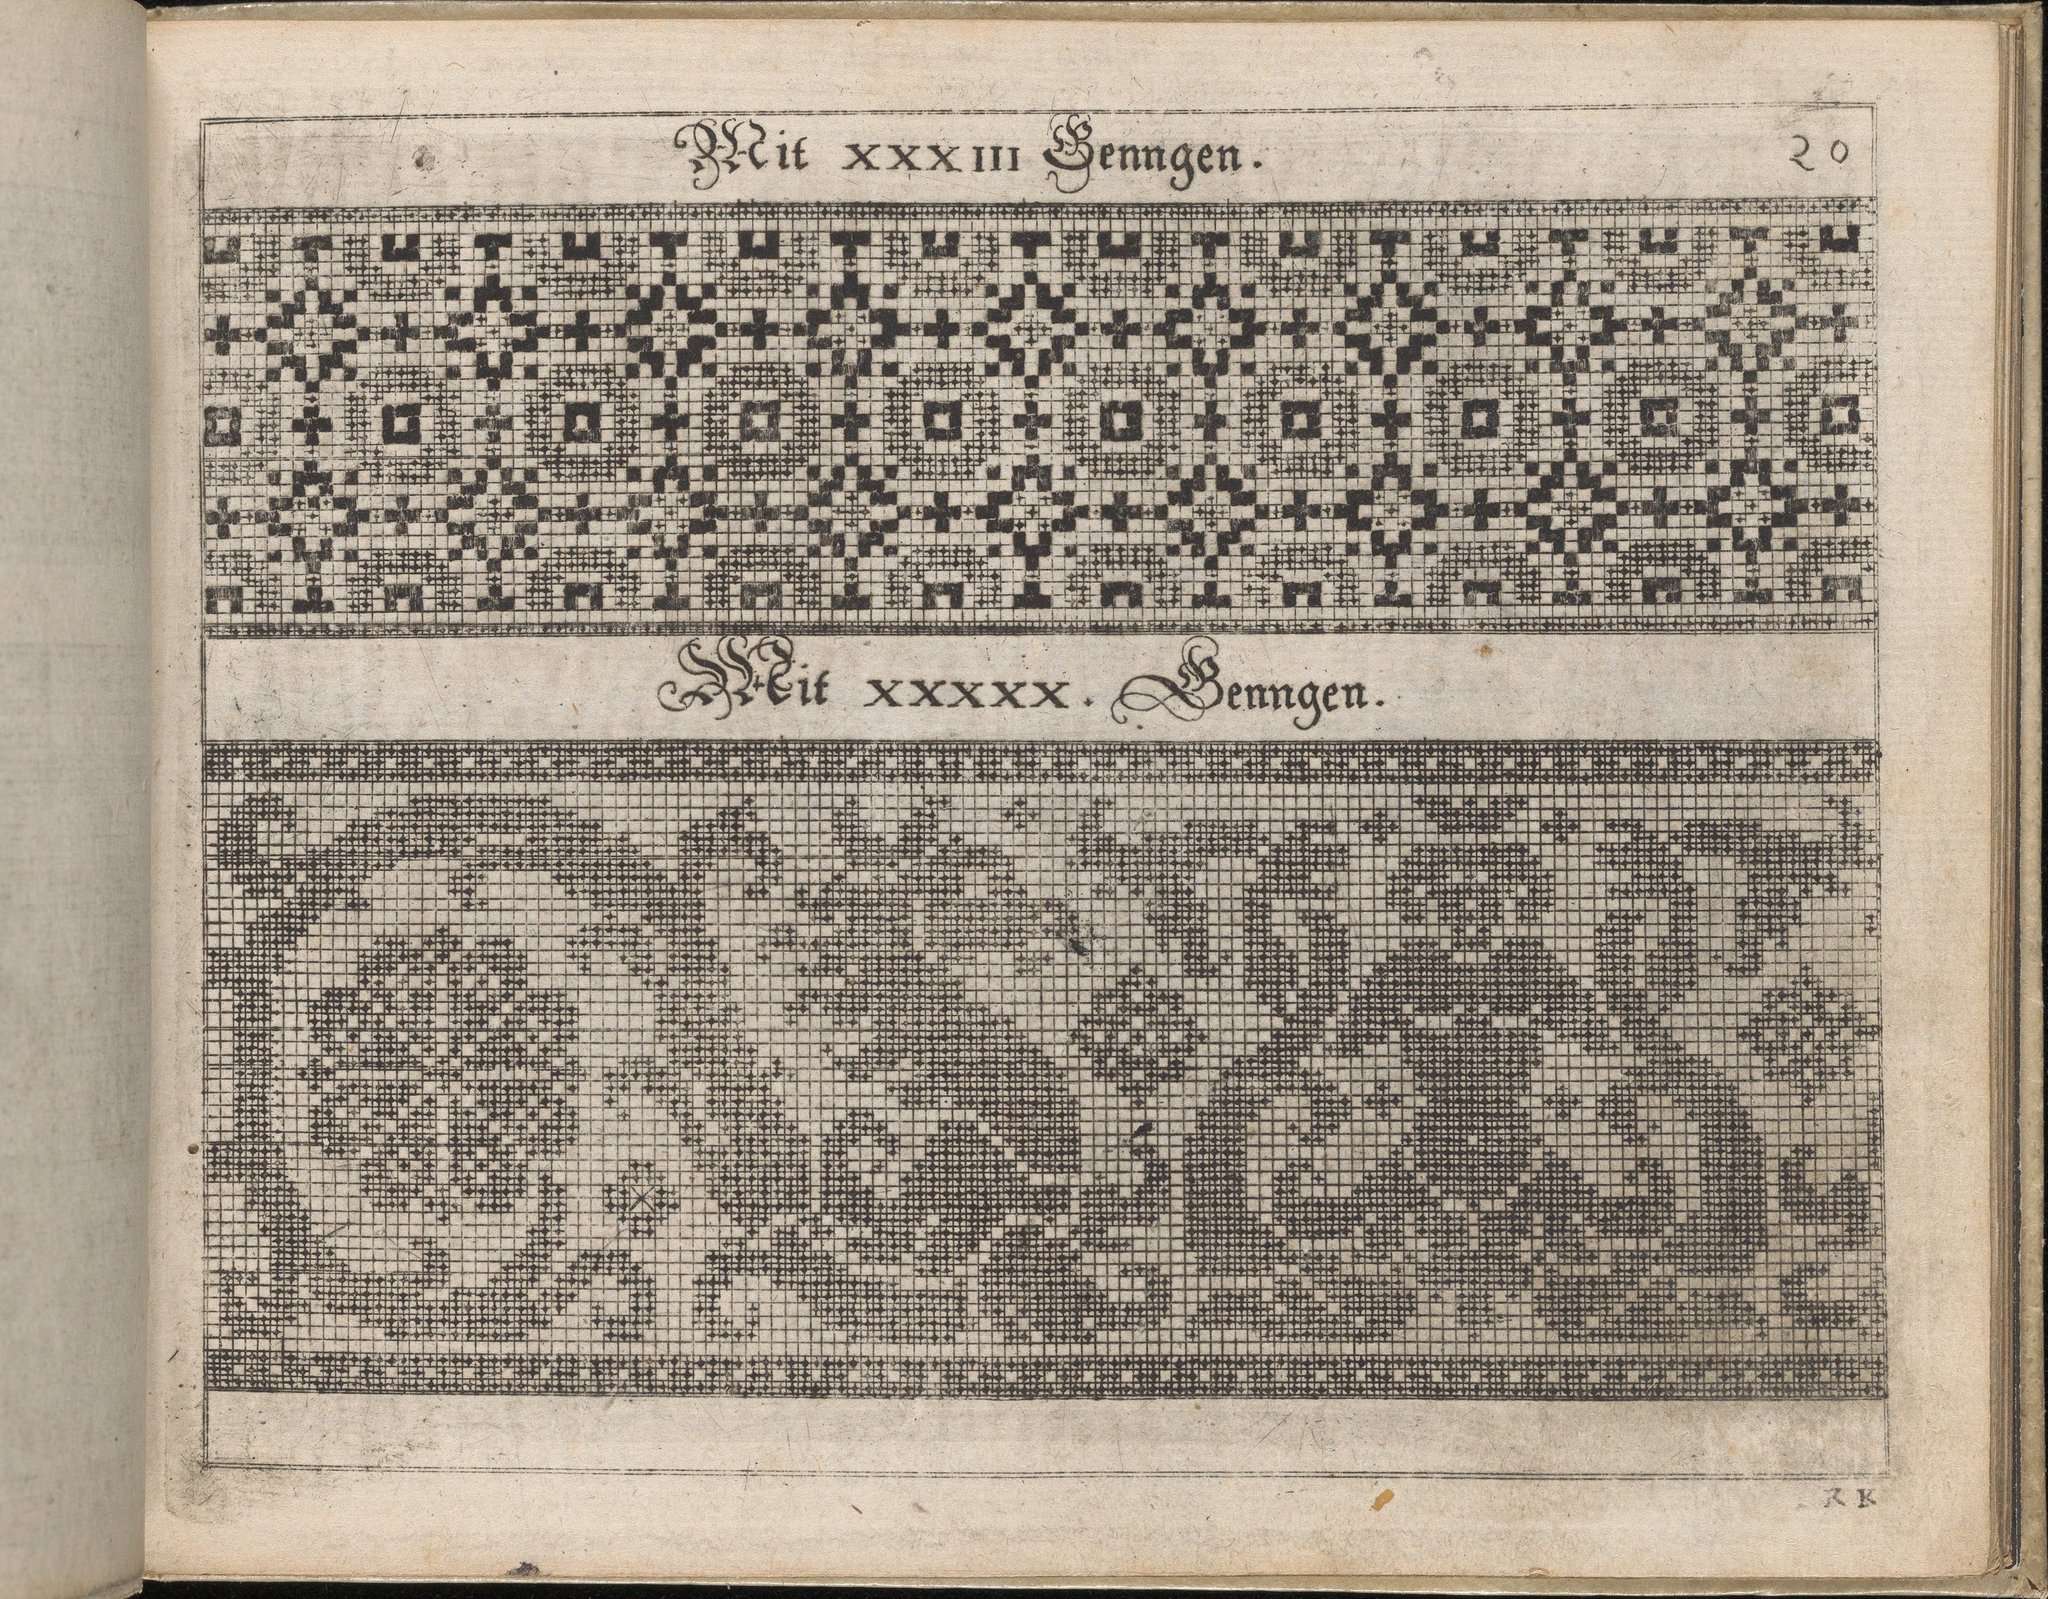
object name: book print ornament architecture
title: Newes Modelbuch in Kupffer (Page 29r)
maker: johann sibmacher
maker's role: artist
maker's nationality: german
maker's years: 1590-1611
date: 1604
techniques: etching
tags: ornament